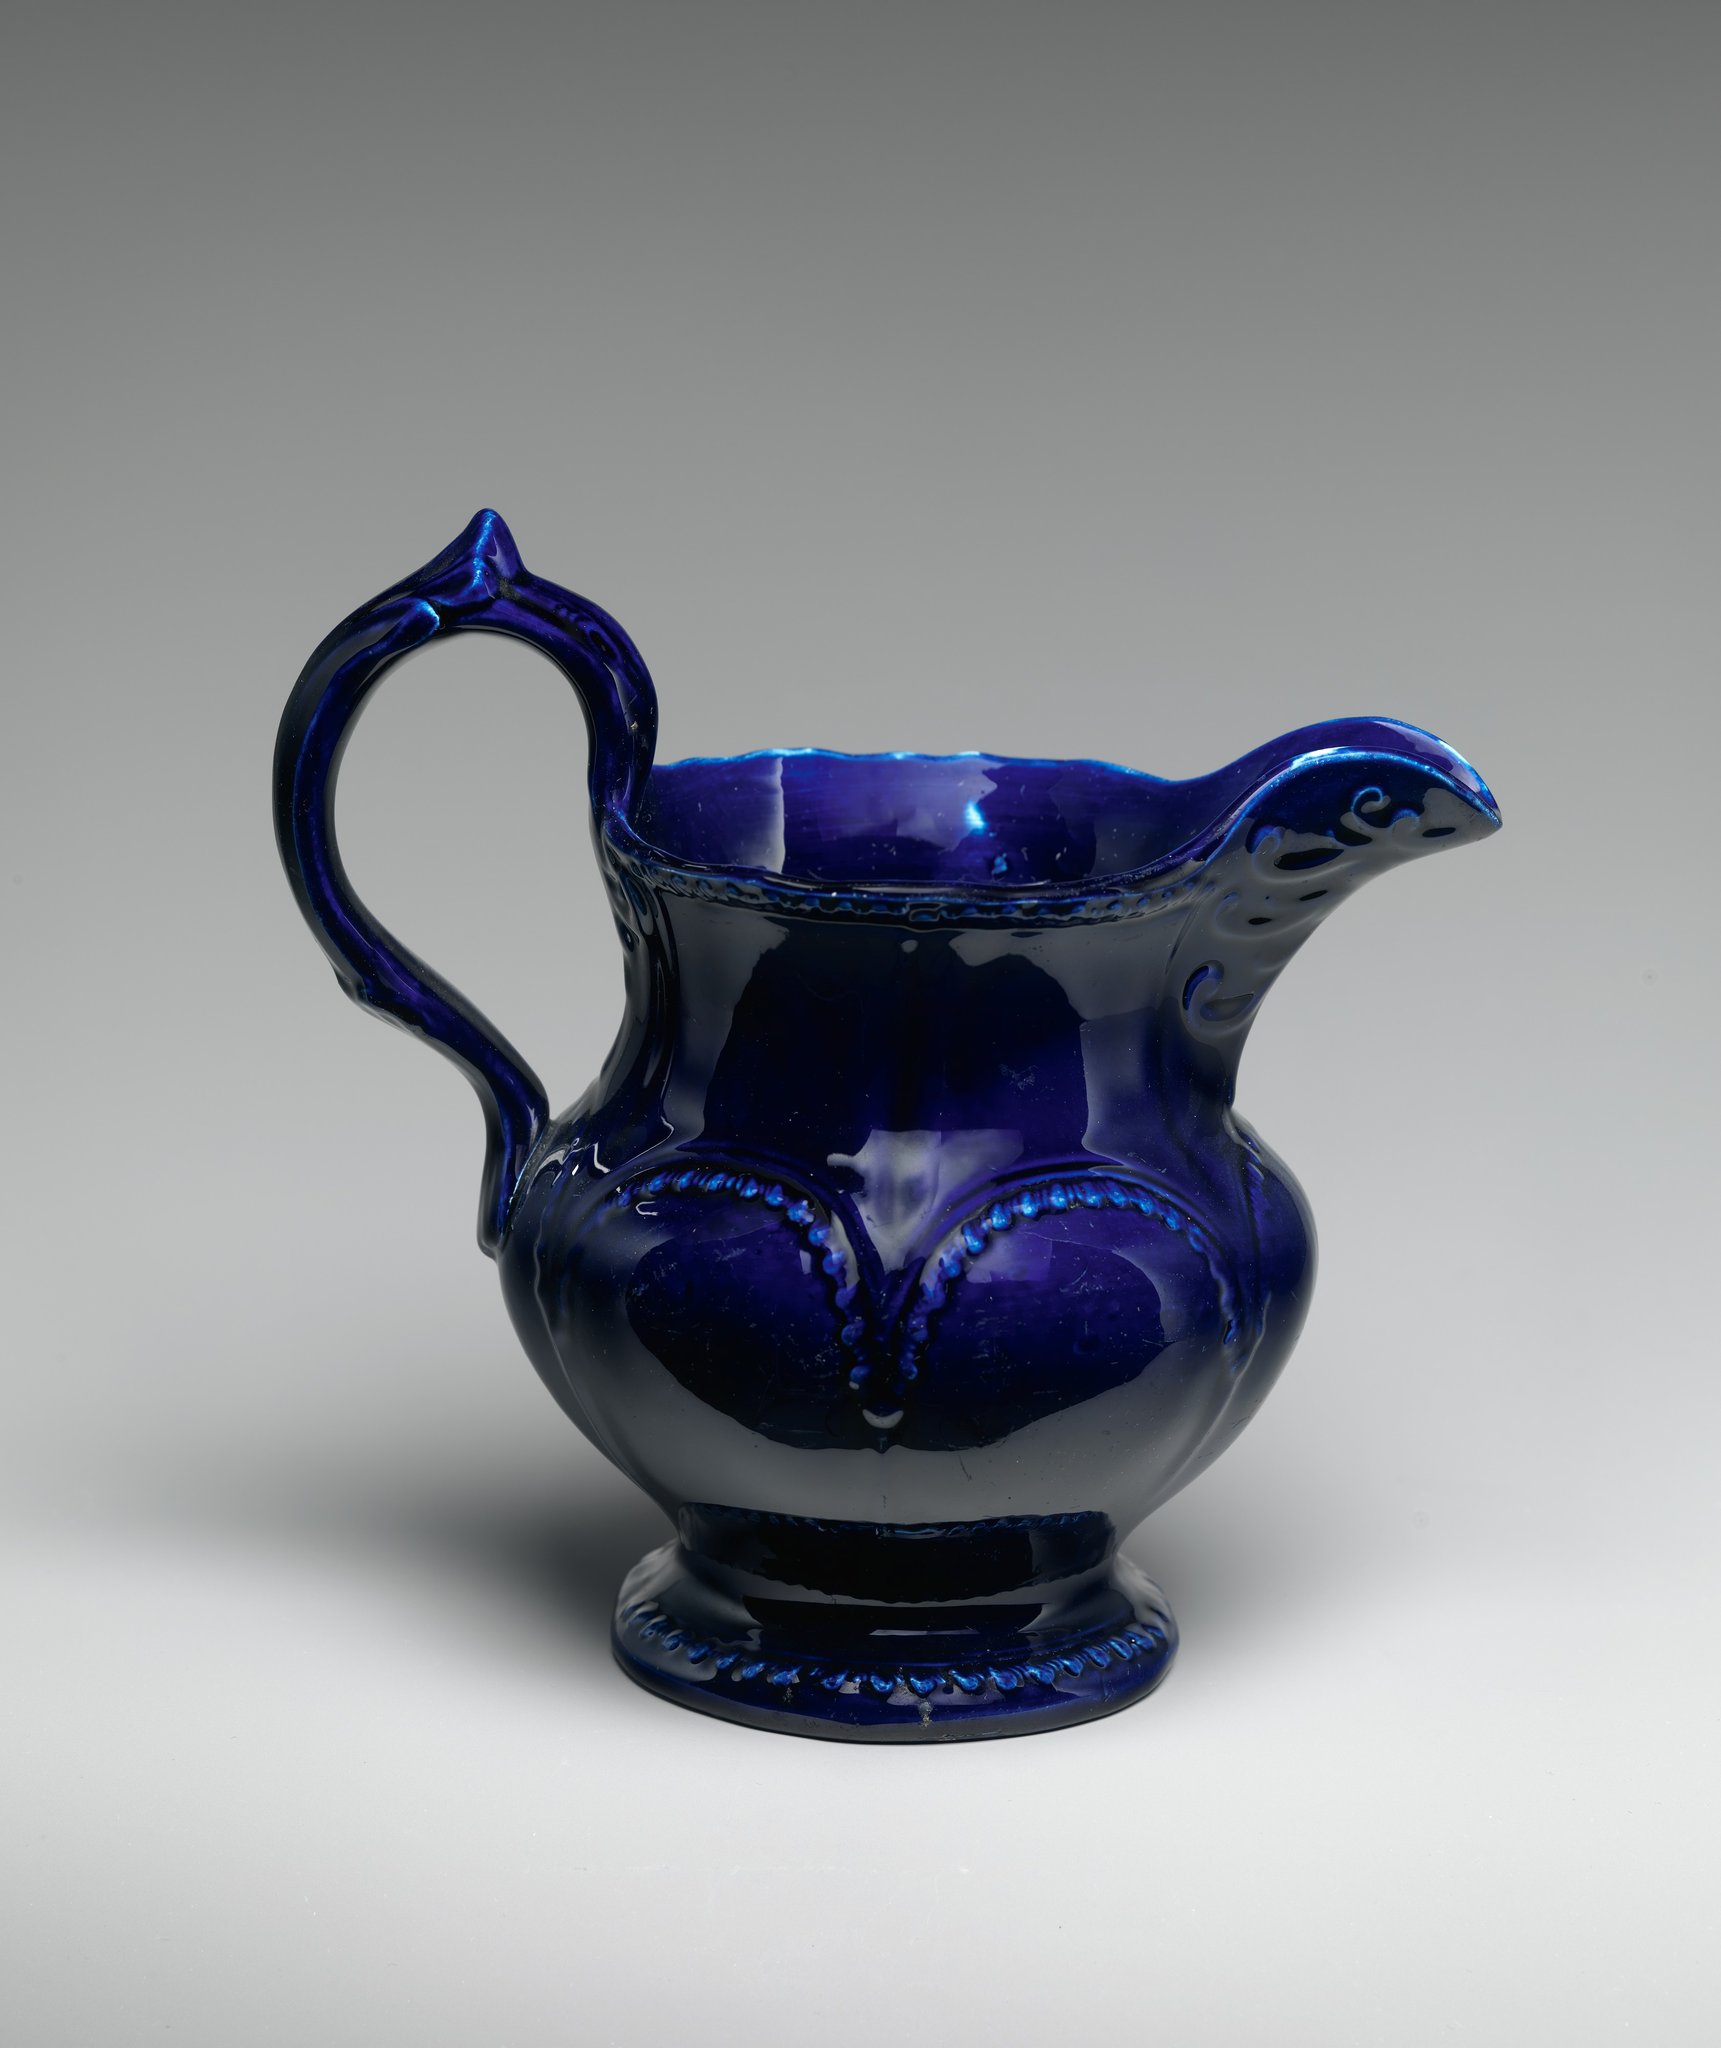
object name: pitcher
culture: american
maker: jersey city pottery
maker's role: maker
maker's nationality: american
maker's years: 1855-1892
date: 1850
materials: earthenware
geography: united states